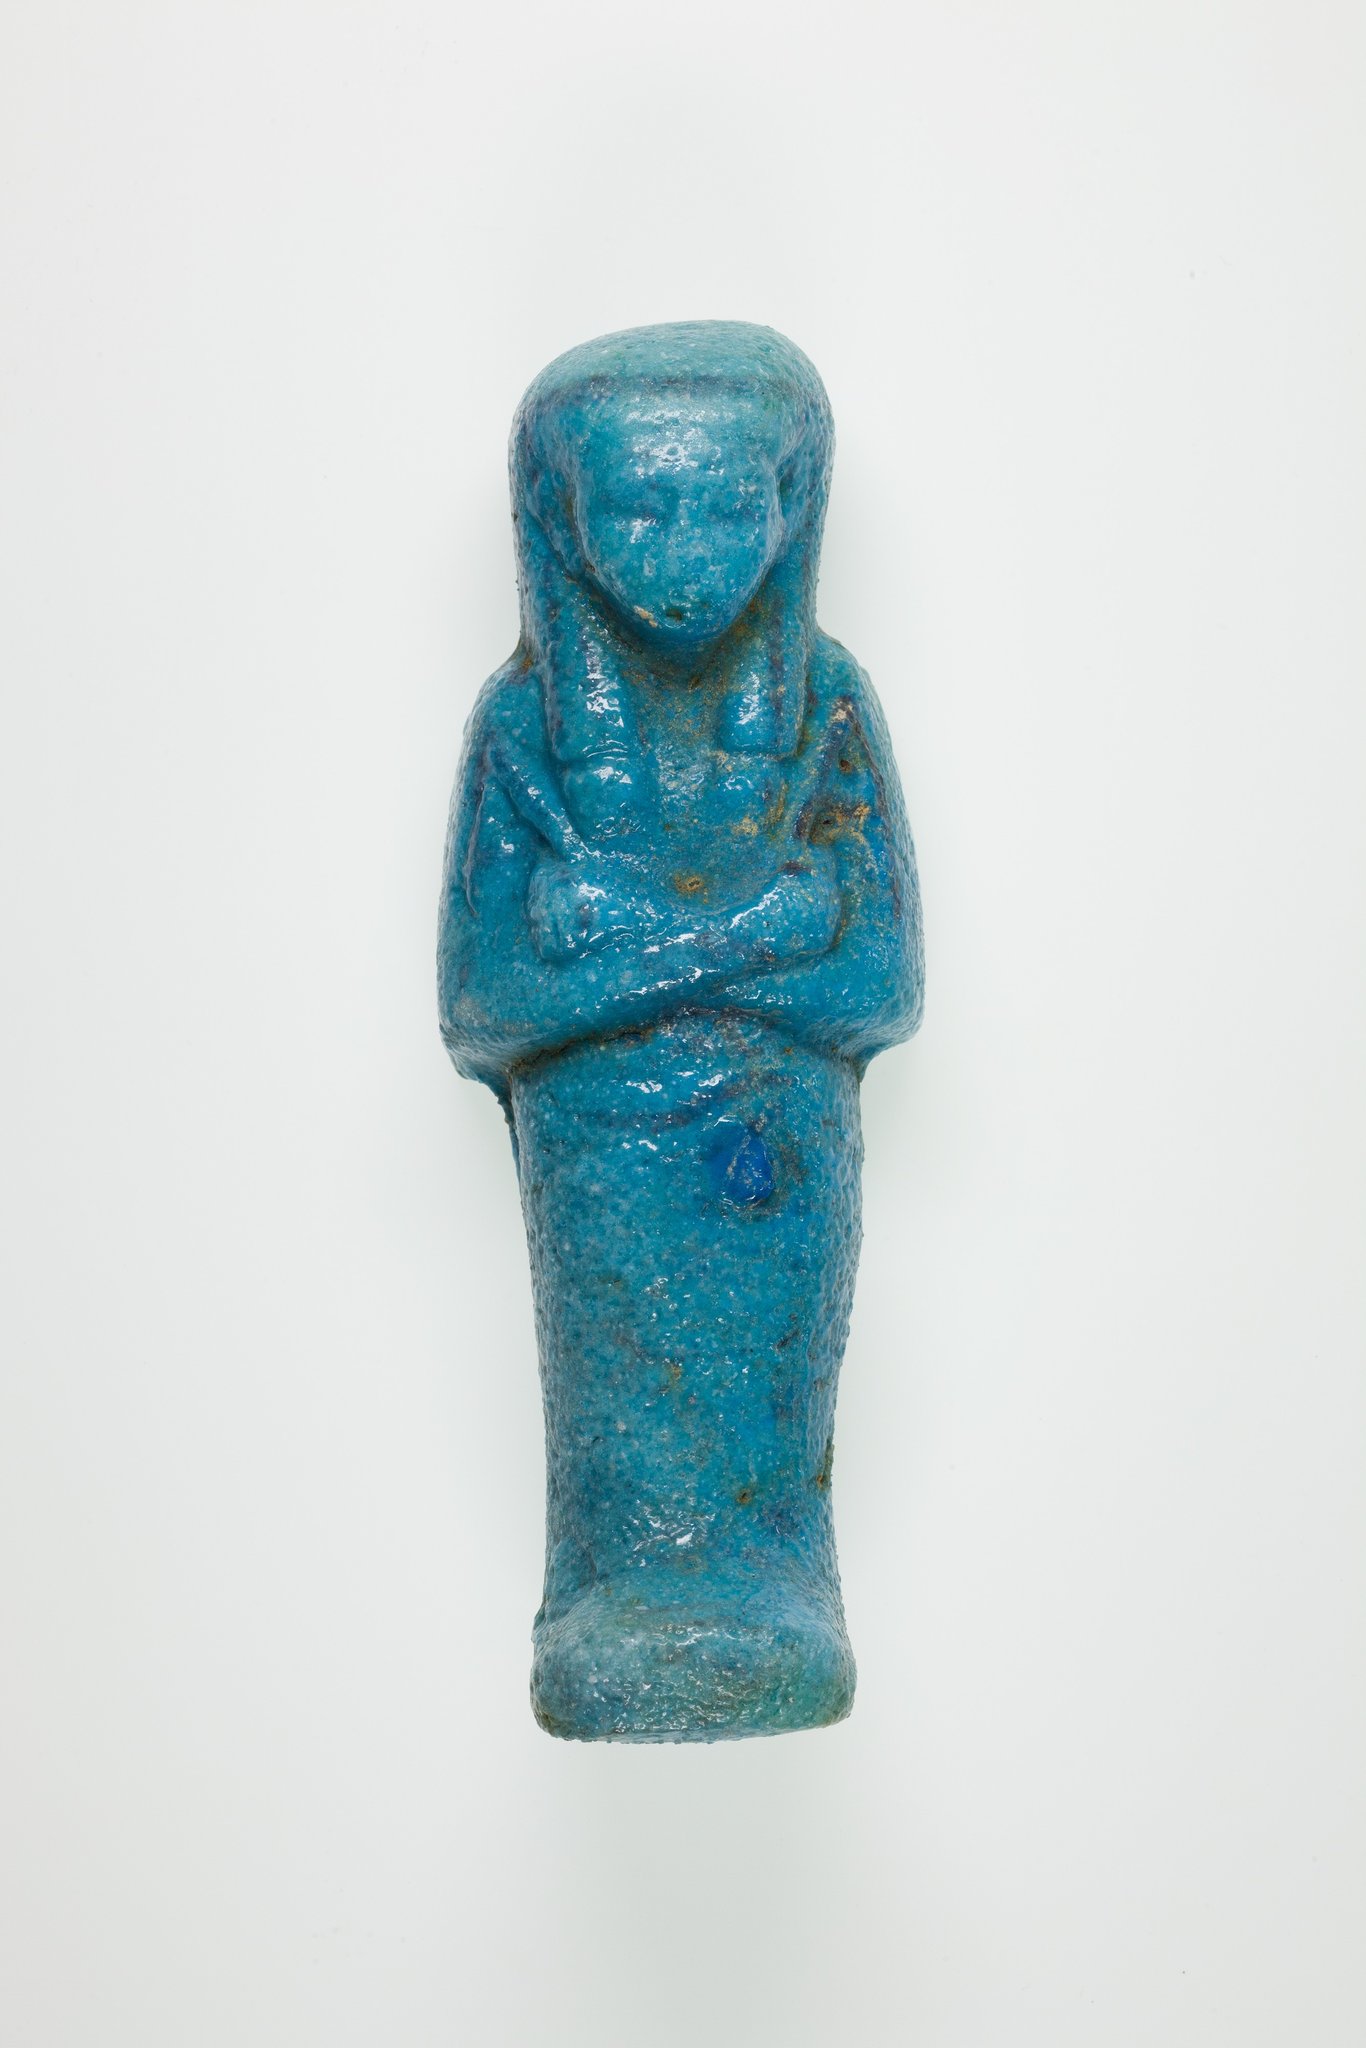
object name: shabti, henettawy c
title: Worker Shabti of Henettawy (C), Daughter of Isetemkheb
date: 990-970 BCE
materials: faience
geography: egypt